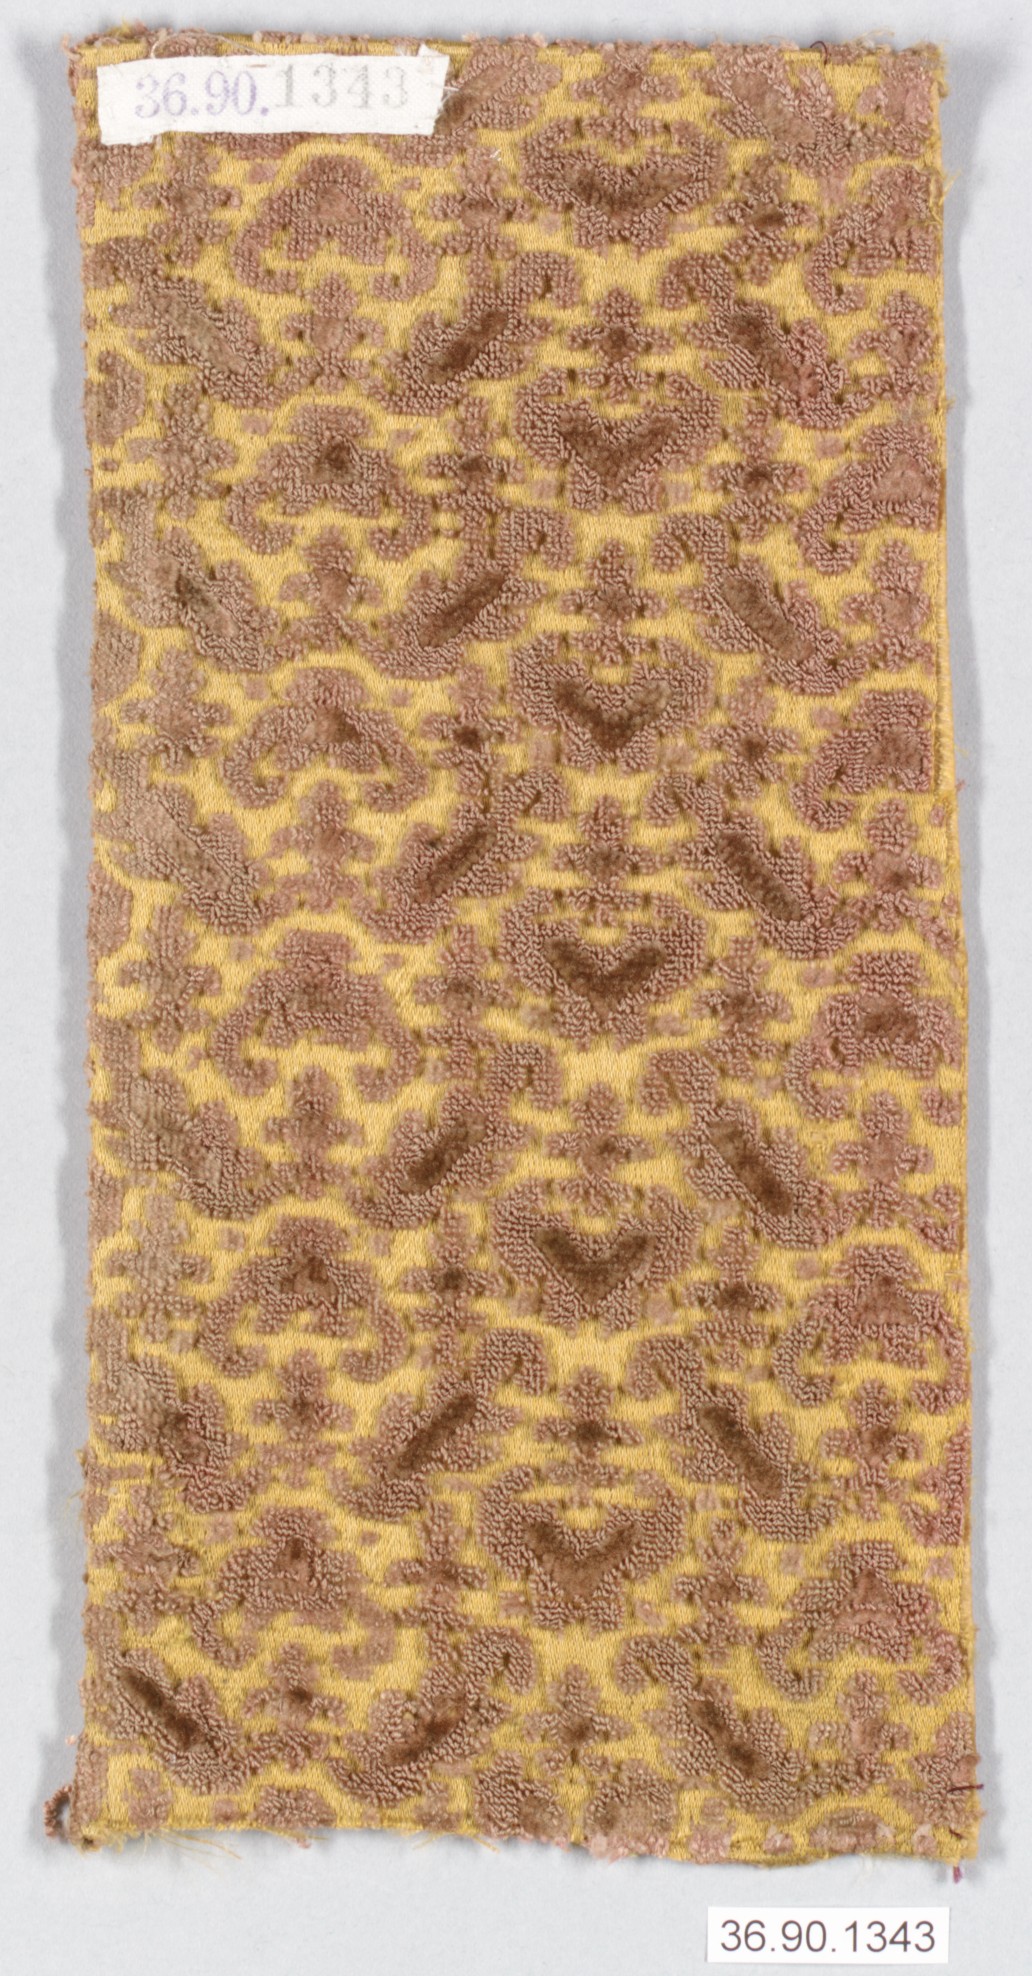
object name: piece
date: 1501-1700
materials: silk